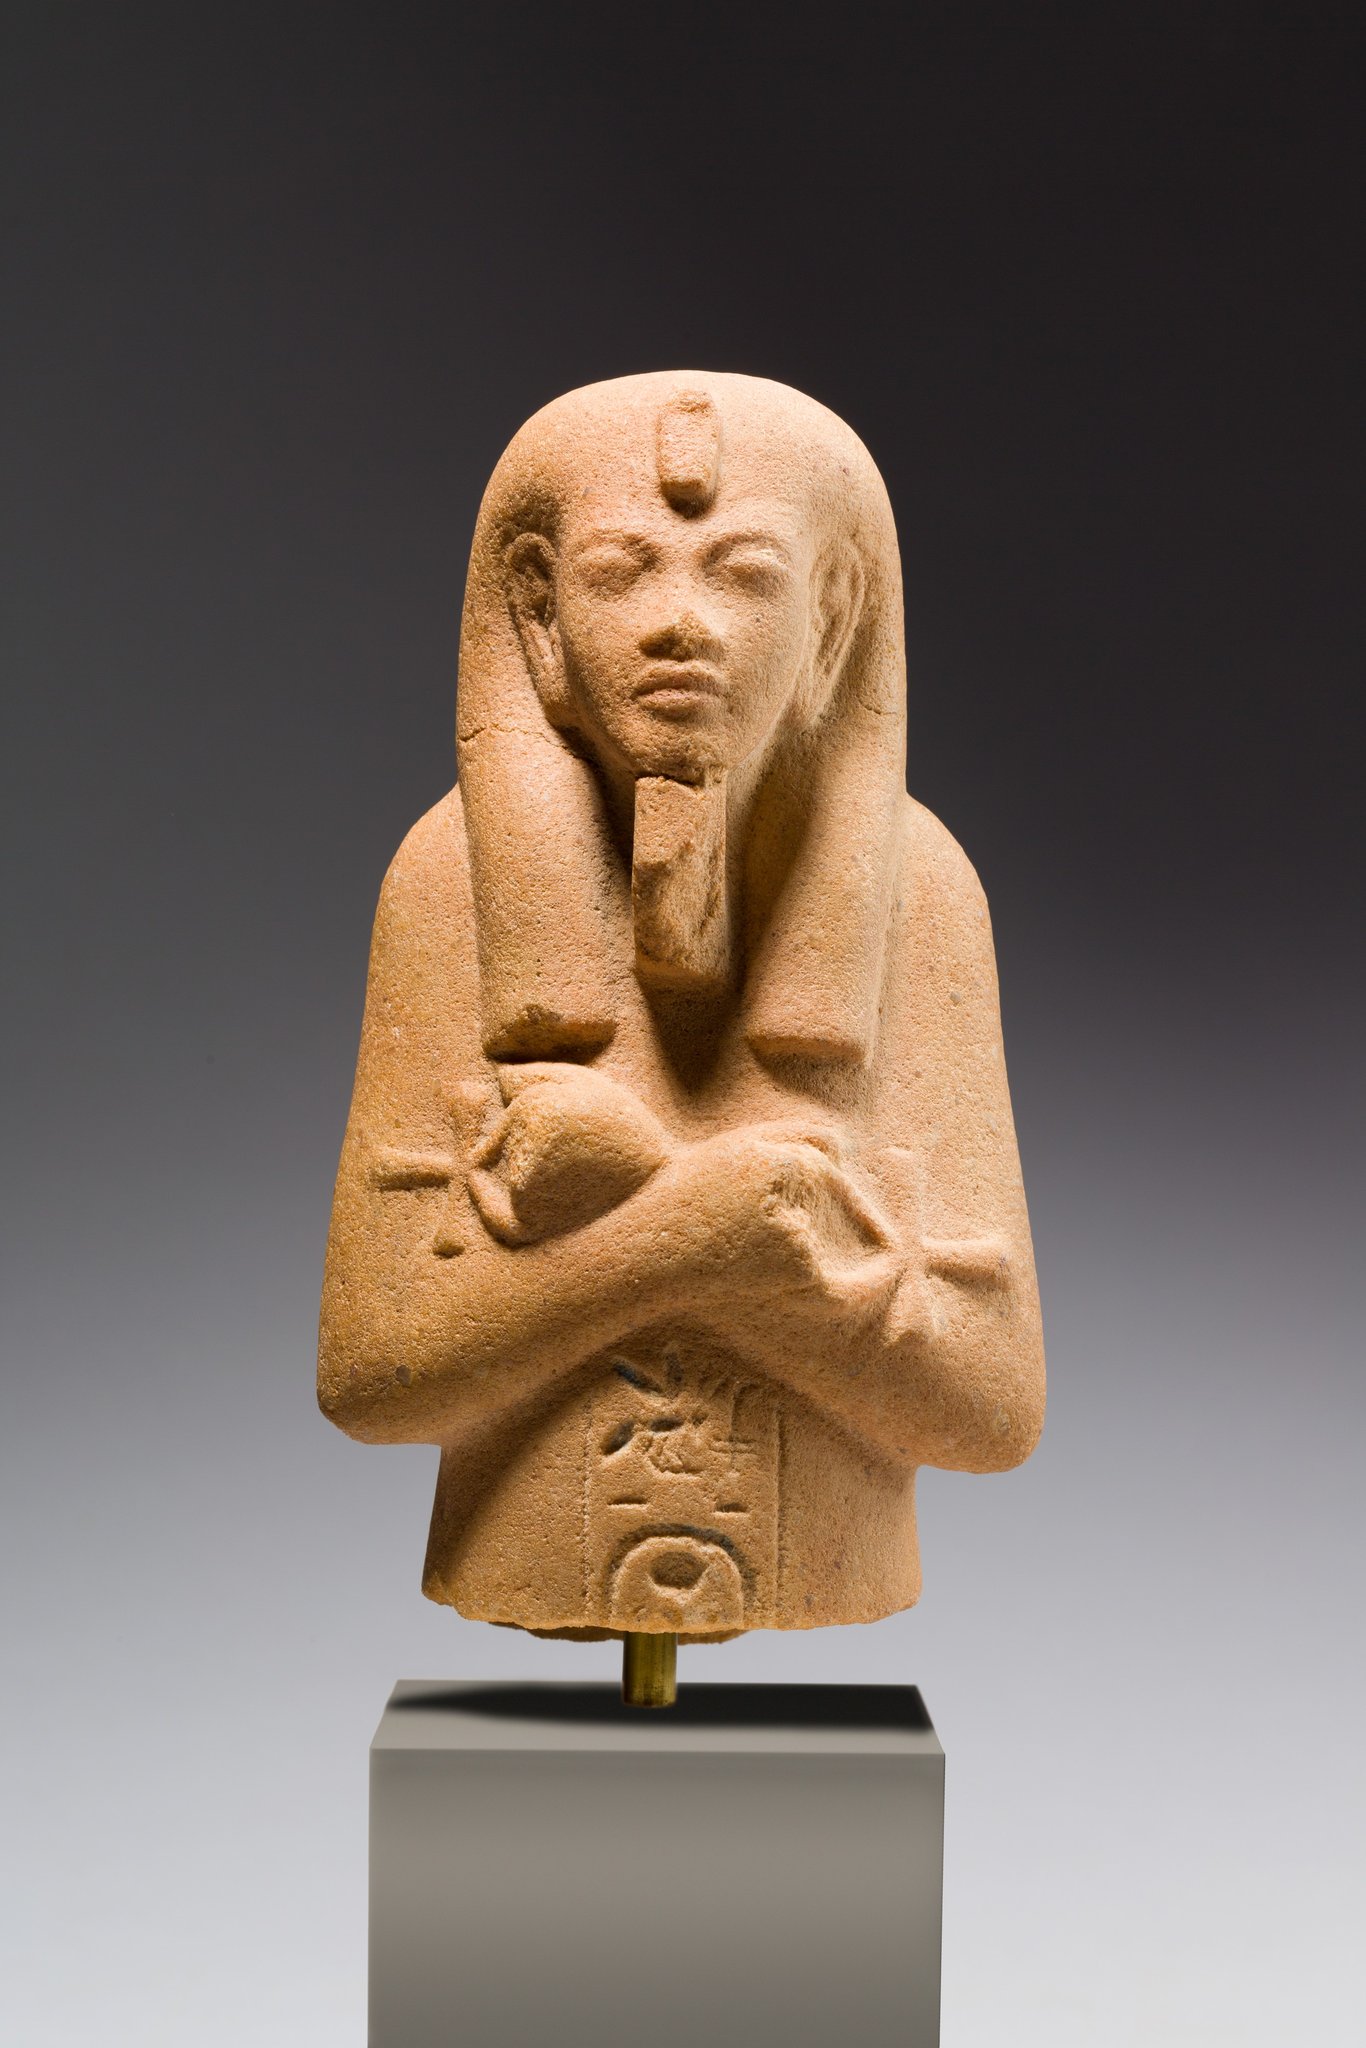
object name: funerary figure, shabti, akhenaten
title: Funerary Figure of Akhenaten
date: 1353-1336 BCE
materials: quartzite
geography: middle egypt